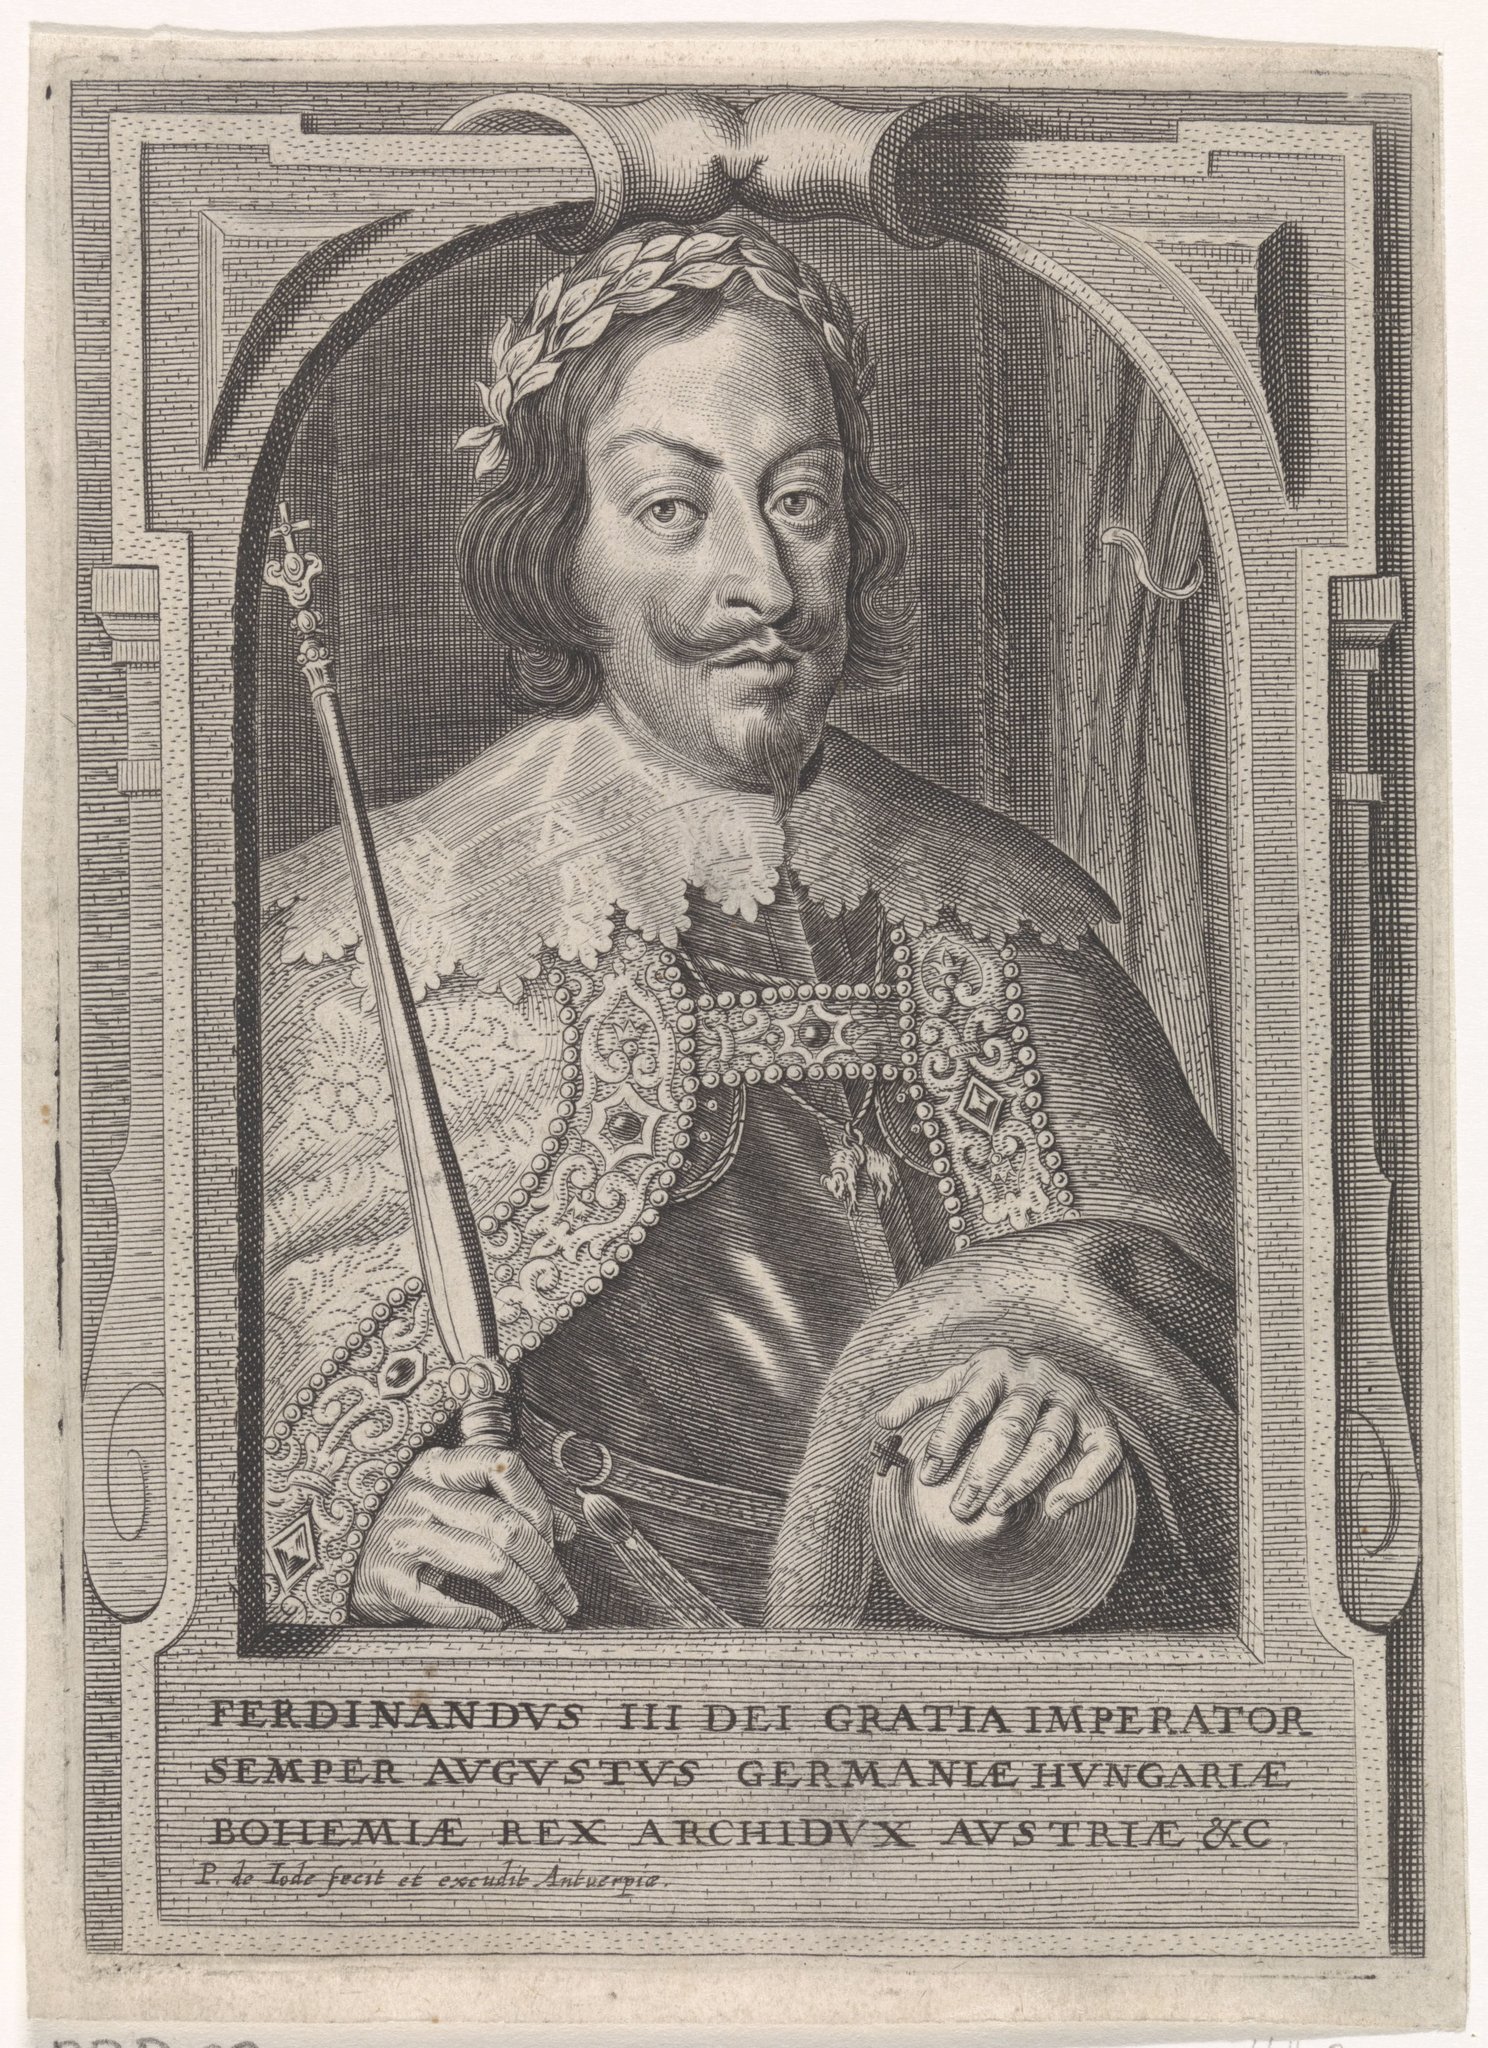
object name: print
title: Theatrum pontificum, imperatorum, regum, ducum, principum, etc.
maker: pieter de jode (ii)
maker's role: draughtsman, print maker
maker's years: 1606-1674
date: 1628-1670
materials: paper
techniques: engraving, etching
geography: antwerp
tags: vienna, ferdinand iii (duits keizer), sceptre, staff (symbol of sovereignty), knighthood order of the golden fleece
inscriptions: collector's mark: Lugt 2228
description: Portret van Ferdinand III, ten halven lijve. Hij draagt een rijkversierde mantel en is gekroond met een lauwerkrans. Hij draagt een ketting met een hanger van de Orde van het Gulden Vlies. In zijn rechterhand houdt hij een scepter en zijn linkerhand rust op een rijksappel. Het portret is gevat in een boogvormige omlijsting. In de marge een drieregelig onderschrift in het Latijn.